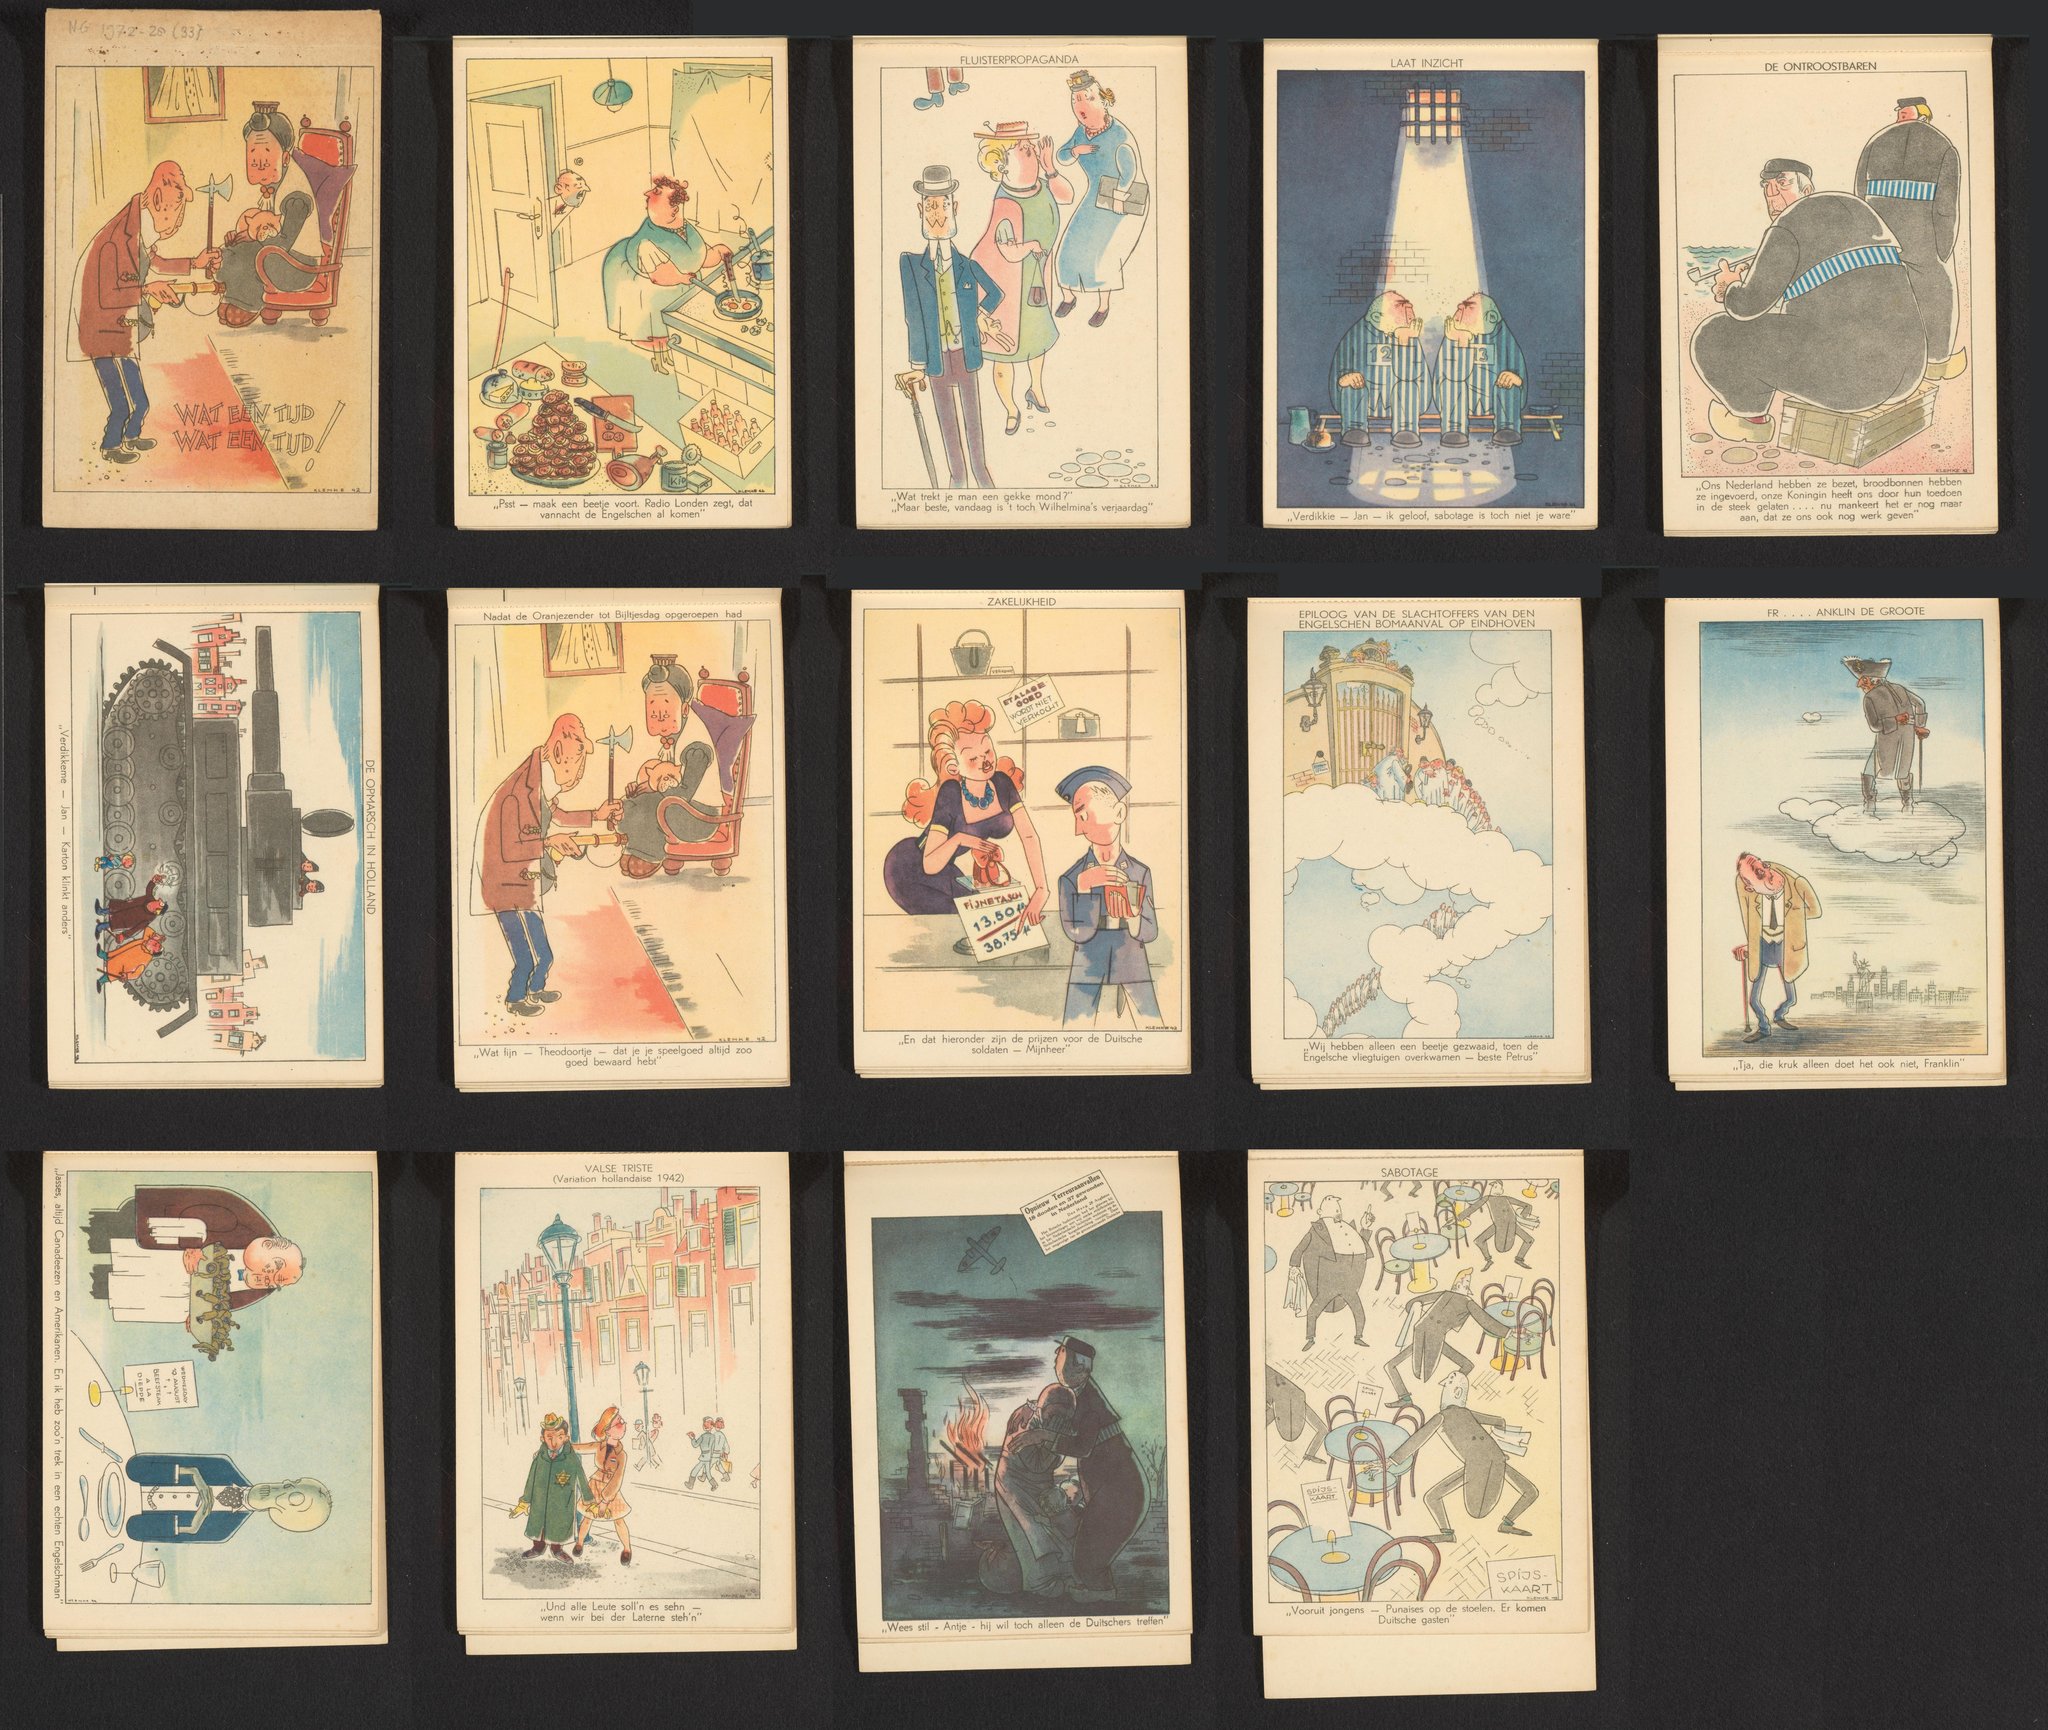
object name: postcard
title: Wat een tijd wat een tijd!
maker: klemke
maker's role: draughtsman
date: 1942-1943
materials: paper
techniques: printing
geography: netherlands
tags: netherlands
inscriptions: date